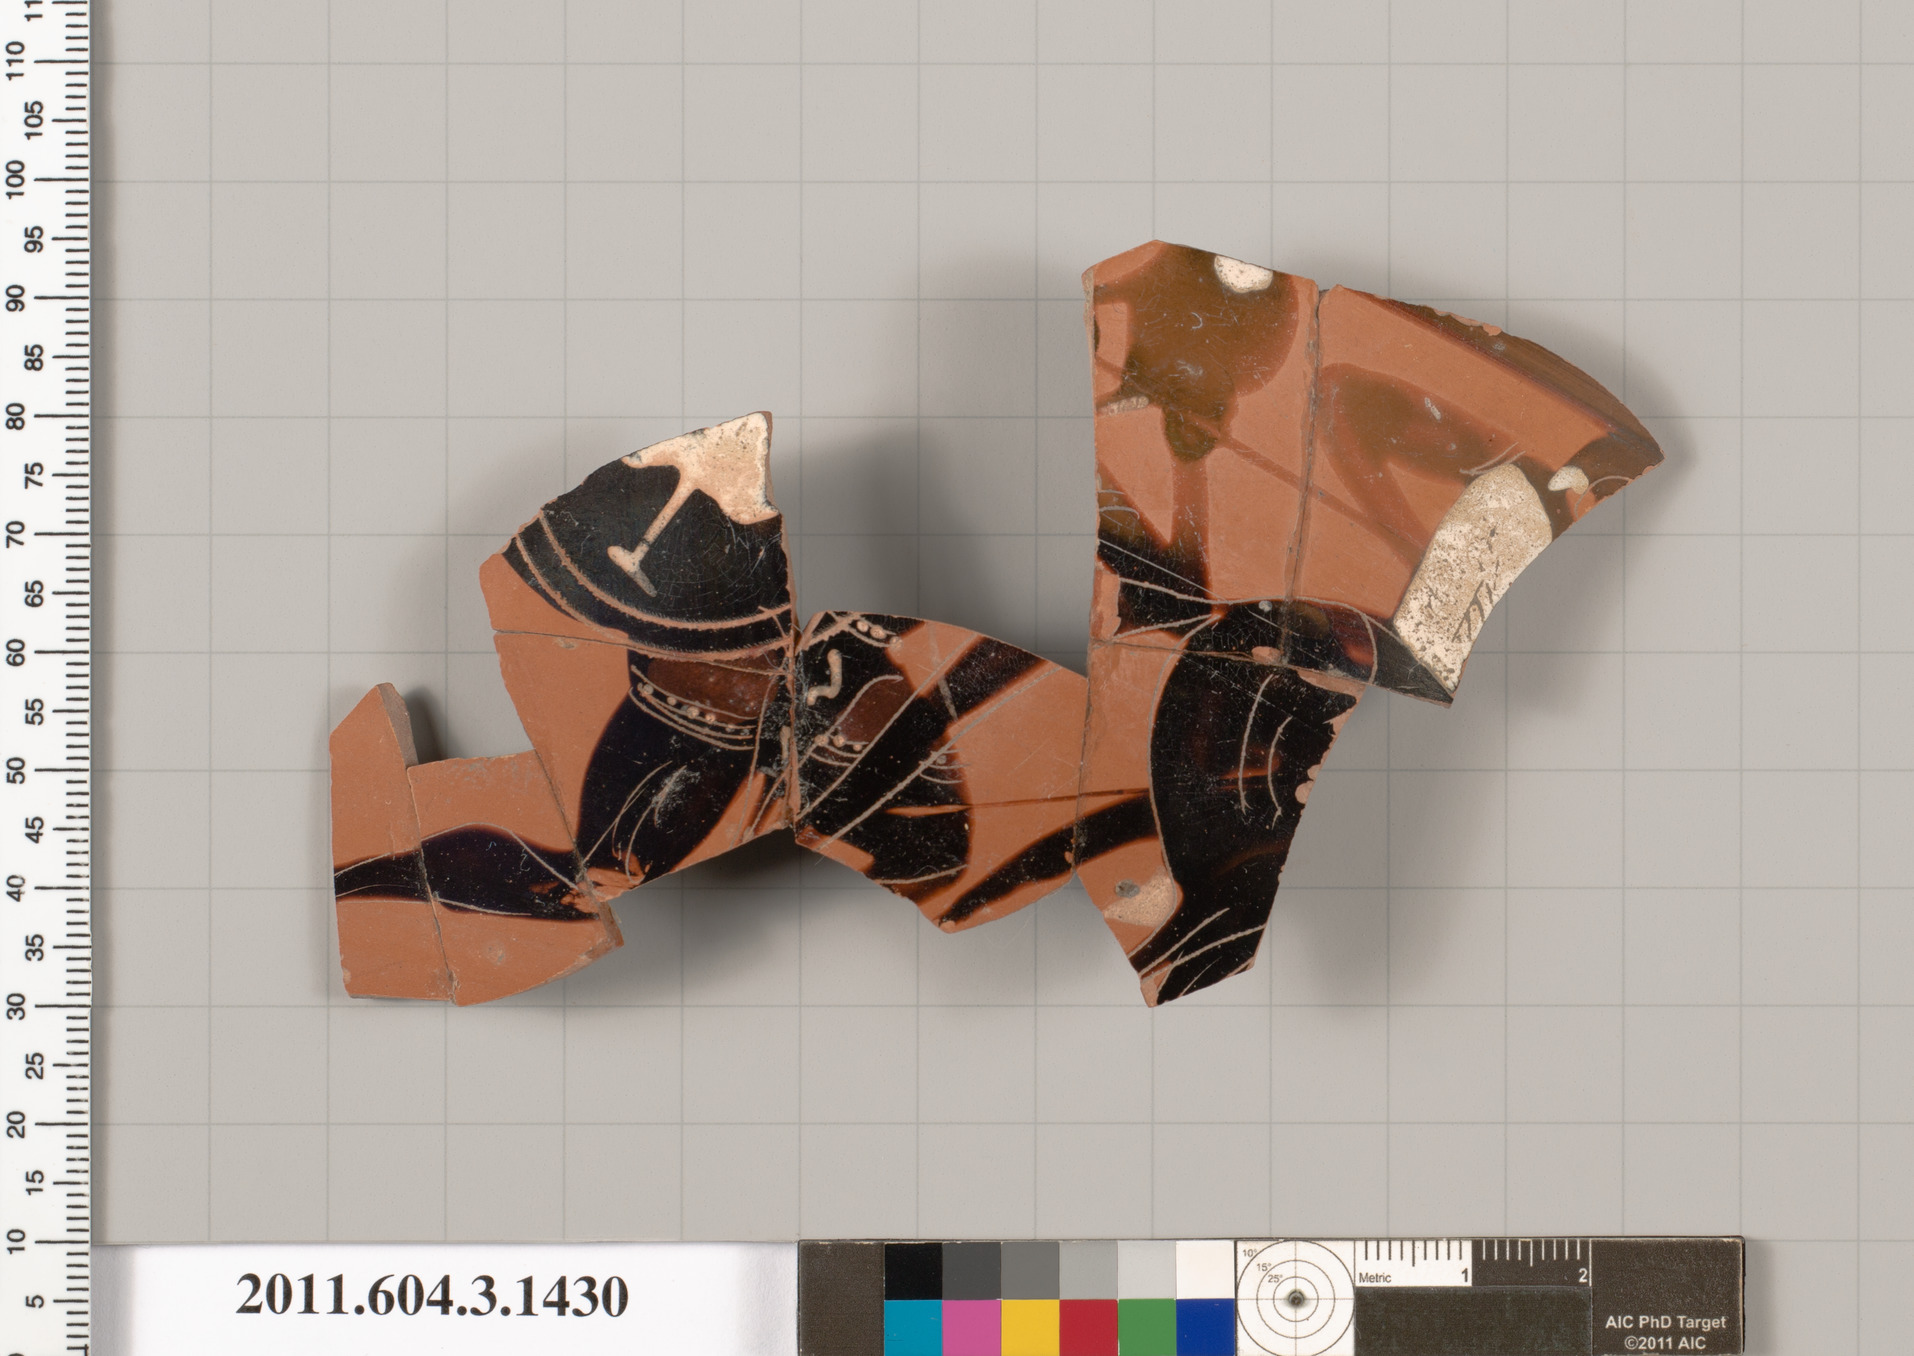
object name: skyphos fragment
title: Terracotta fragment of a skyphos (deep drinking cup)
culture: greek, attic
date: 550-501 BCE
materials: terracotta